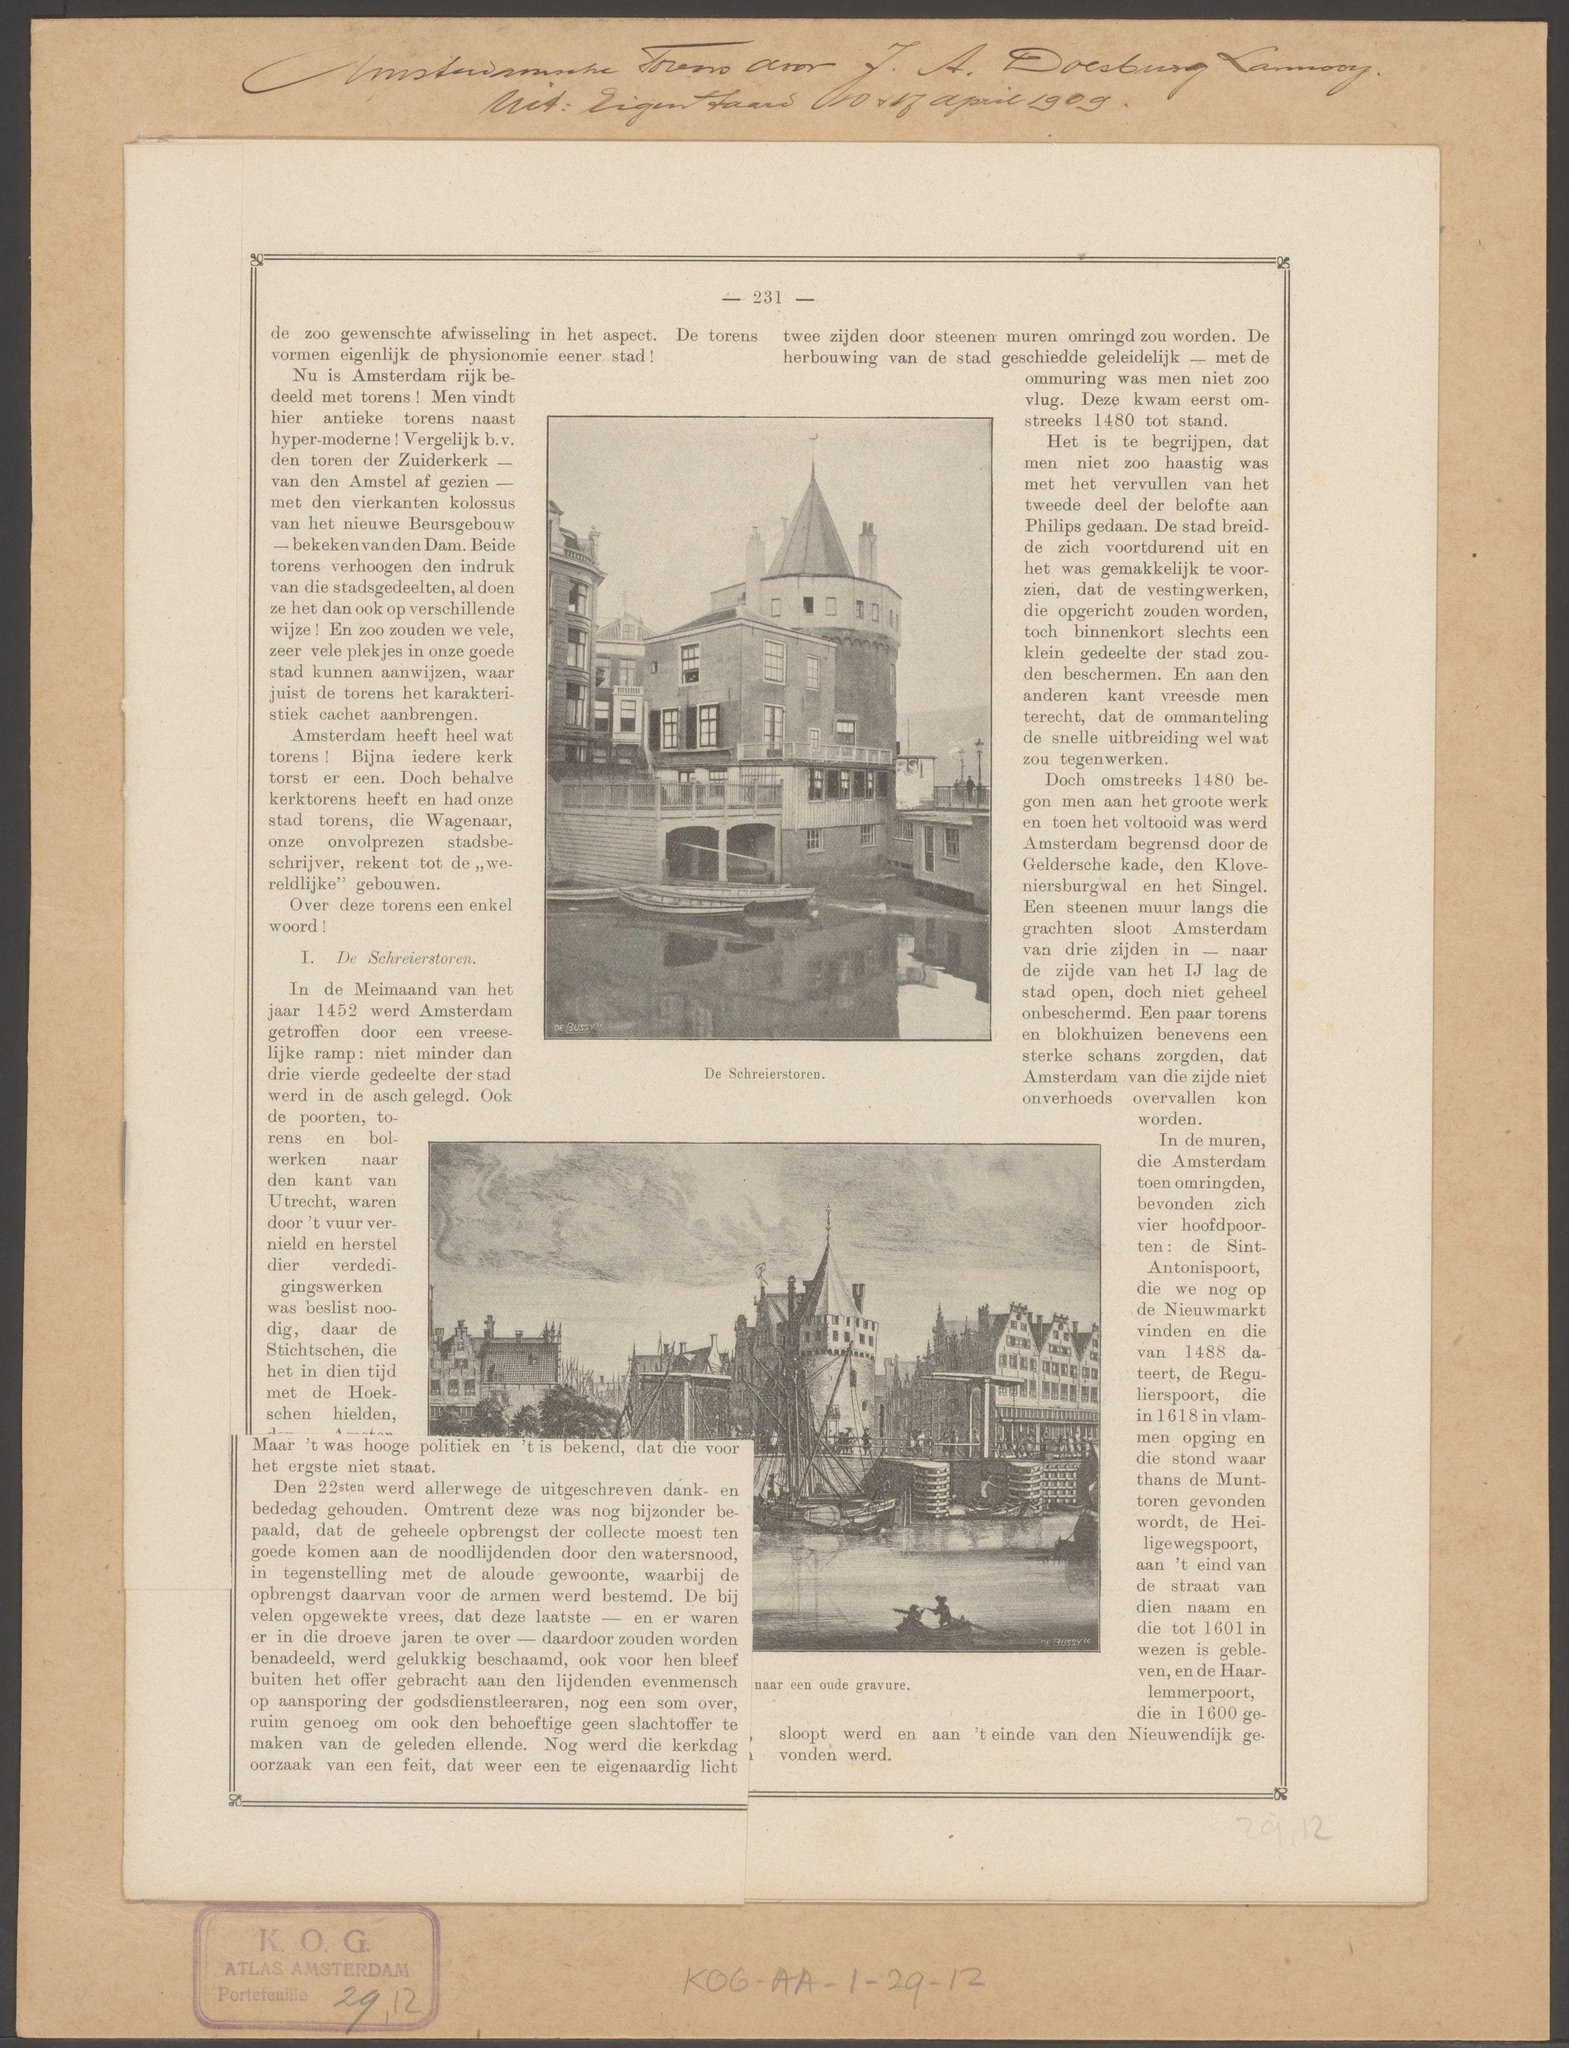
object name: photomechanical print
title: Artikel over zes verschillende torens te Amsterdam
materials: paper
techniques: letterpress printing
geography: amsterdam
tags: tower, clock tower ~ monumental adornment, canals, waters (in city)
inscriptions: collector's mark: Lugt 1641b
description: Object bestaat uit vier volledige en drie verknipte pagina's. Het betreft een artikel dat over twee opeenvolgende publicaties van Eigen Haard verscheen. Fotomechanische afdrukken op pagina 231-233, 235 en 248-250. Onderwerpsrubriek binnen de Atlas Amsterdam: Torens, verzamelbladen.